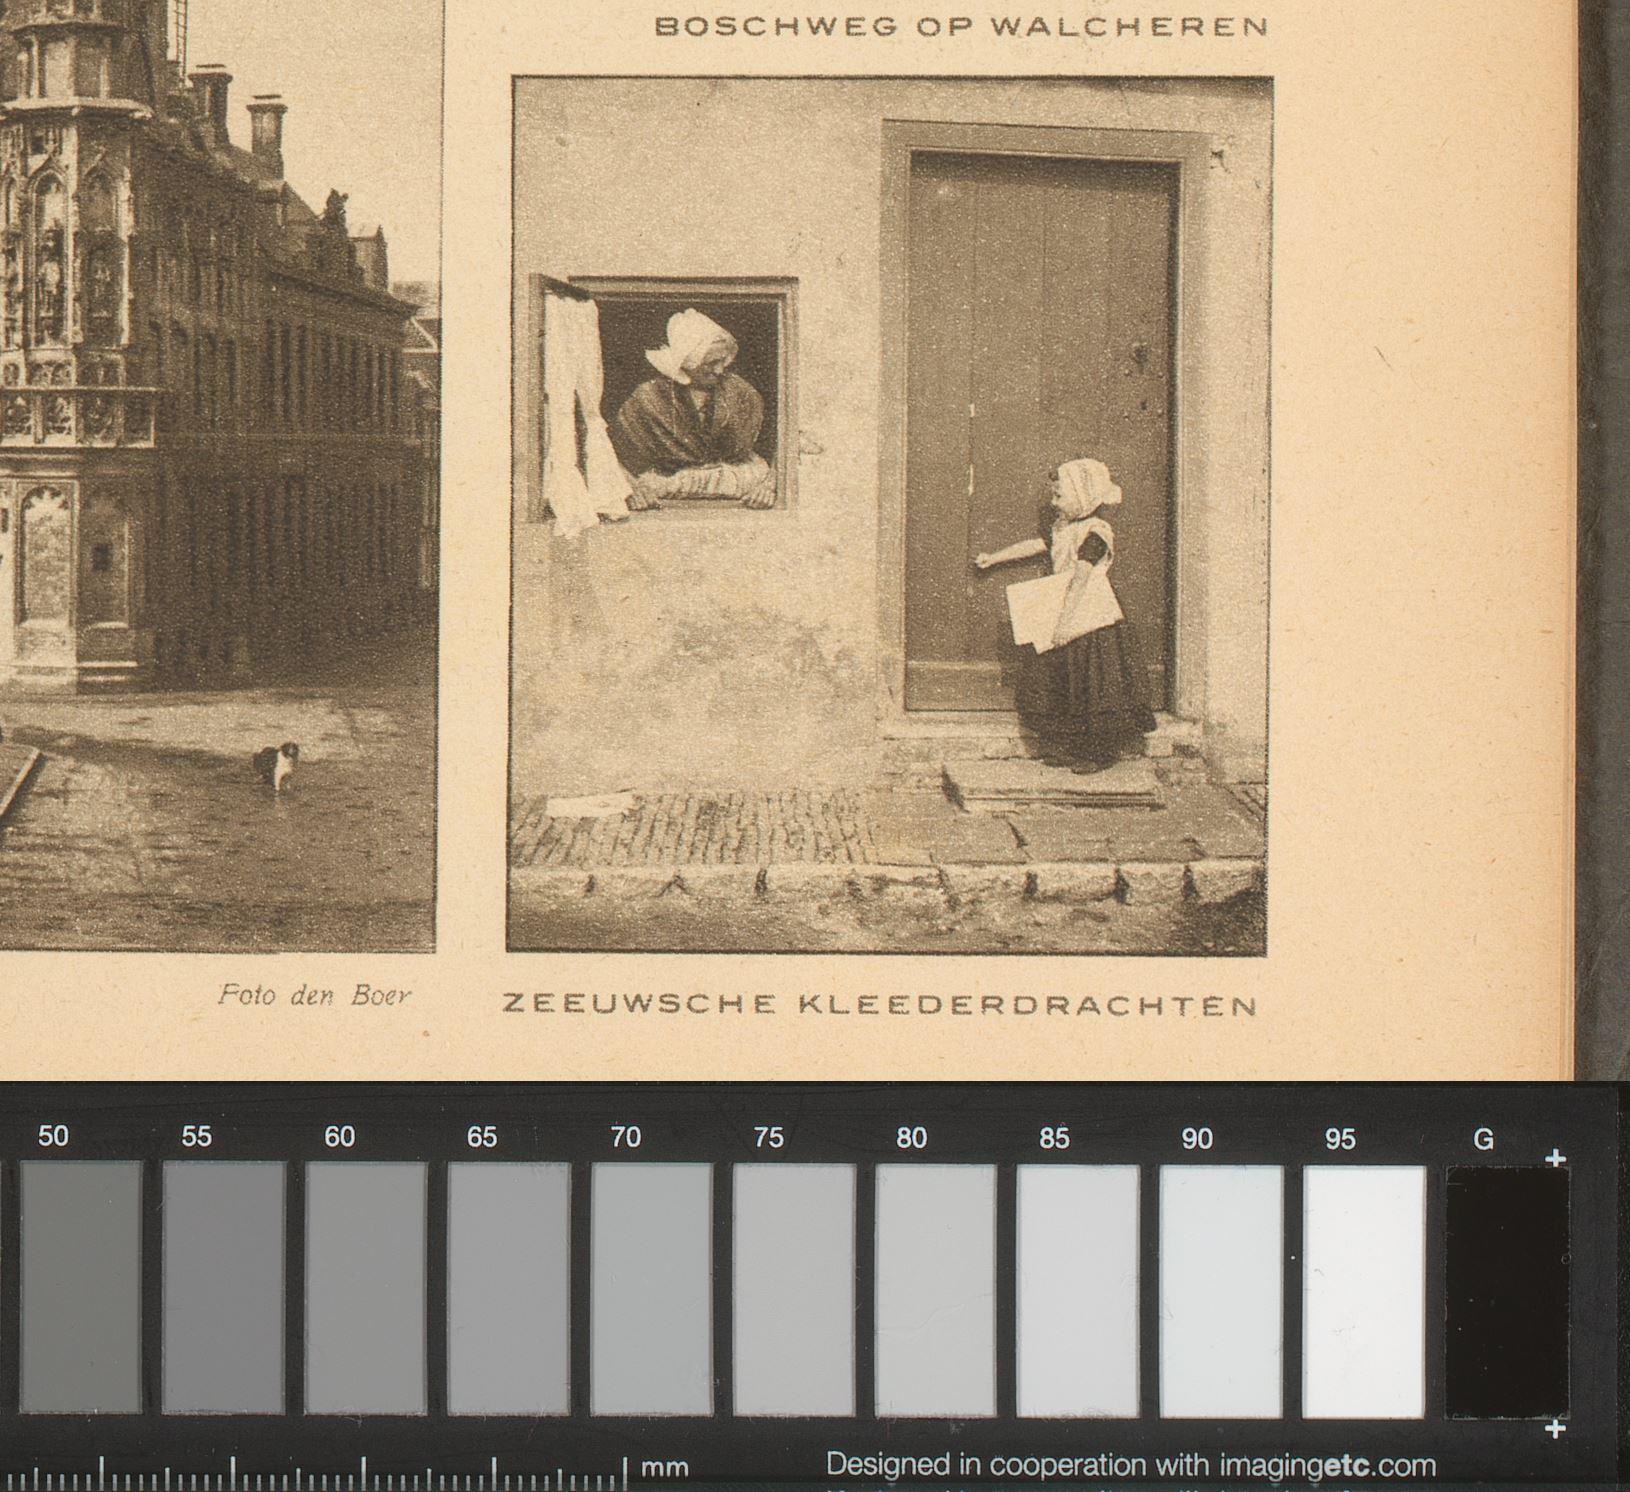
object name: album leaf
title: Zeeuwsche kleederdrachten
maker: Anonymous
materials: paper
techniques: rotogravure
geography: zeeland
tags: adult woman, girl (child between toddler and youth), folk costume, regional costume, civic architecture; edifices; dwellings, zeeland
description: Deze prent maakt deel uit van een album.